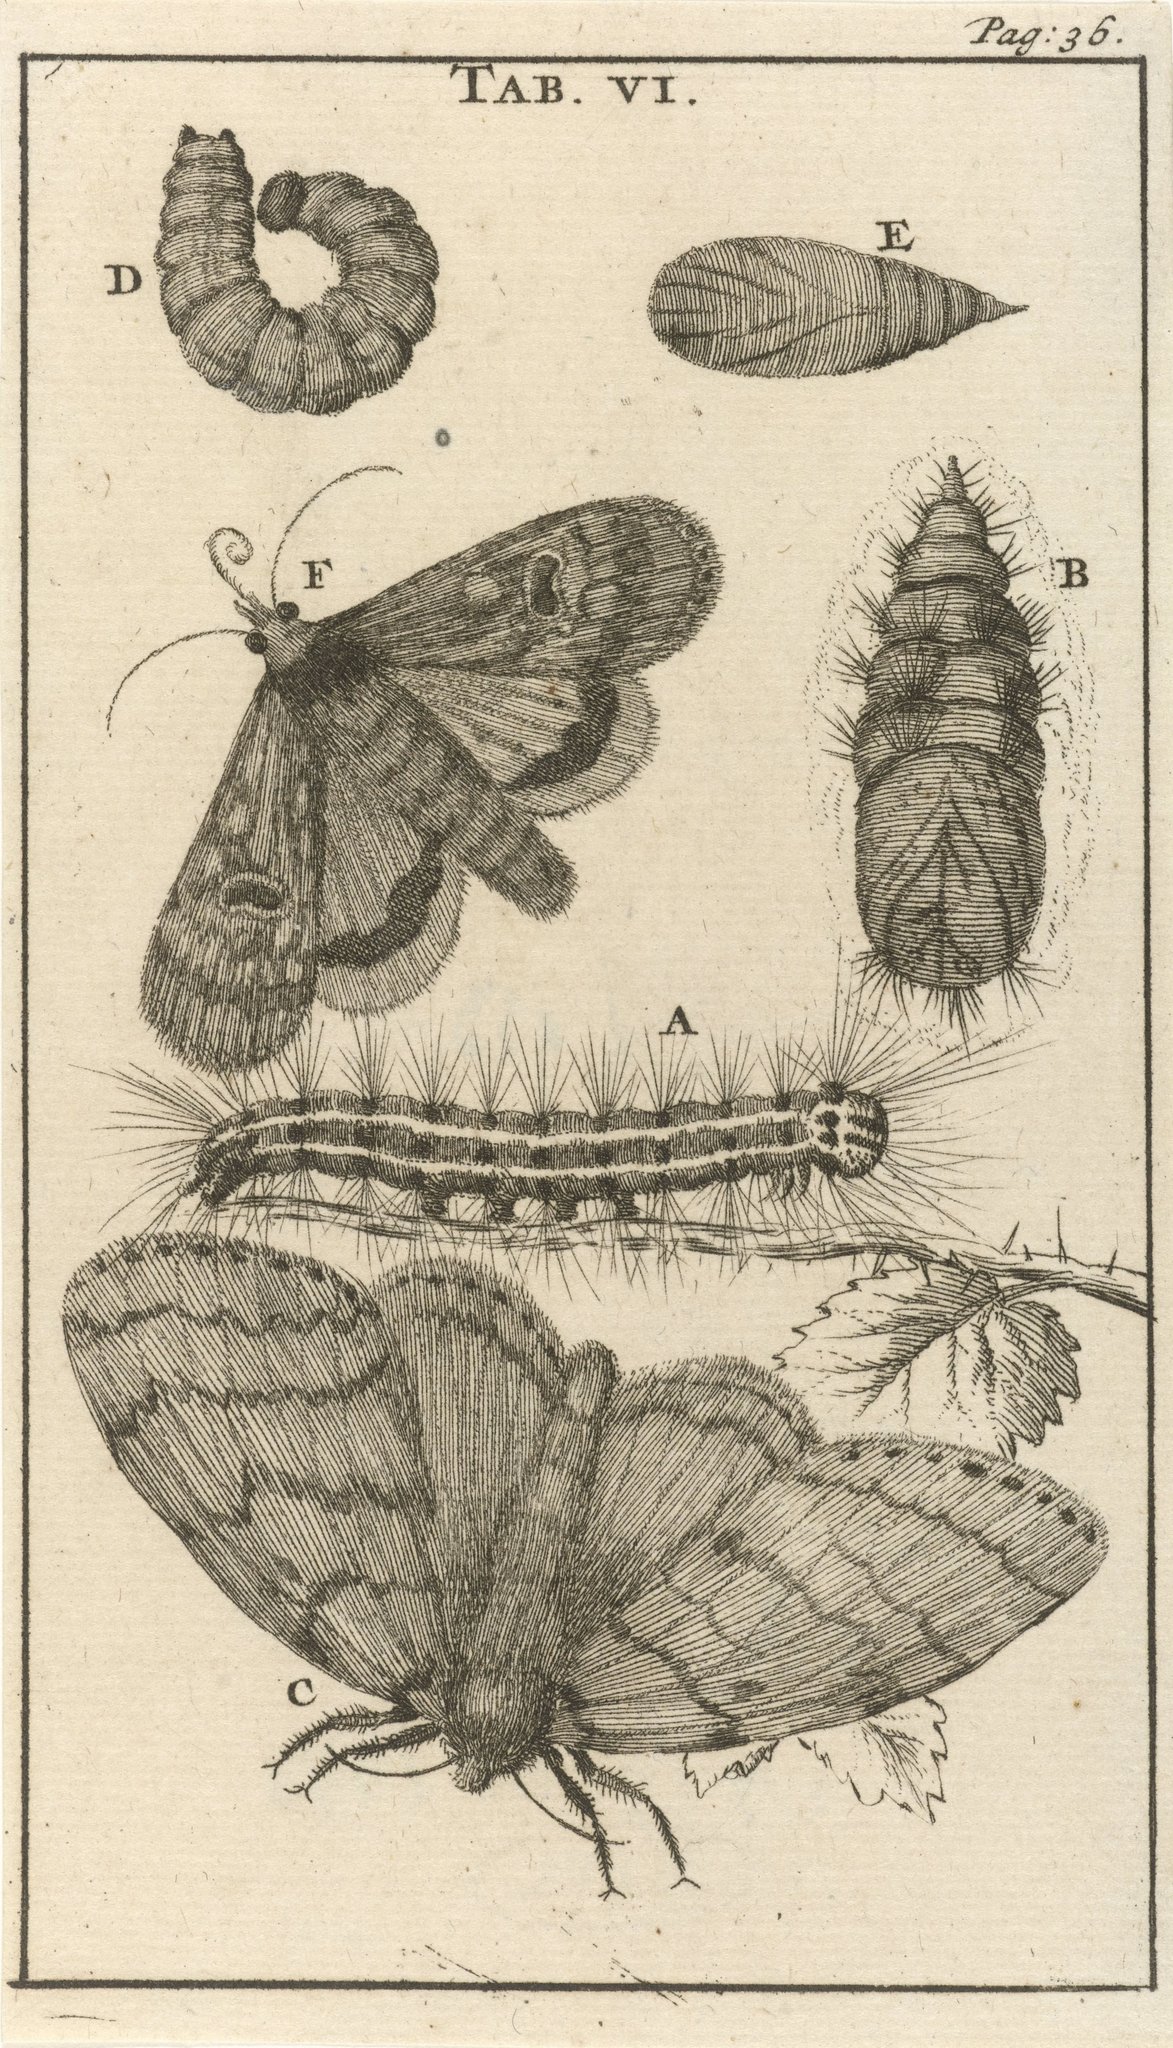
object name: print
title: Rupsen, poppen en vlinders VI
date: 1680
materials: paper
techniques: etching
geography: amsterdam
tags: insects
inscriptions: collector's mark: Lugt 2228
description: Illustratie opgenomen in: Blankaart, Steven. Schou-burg der rupsen, wormen, ma'den, en vliegende dierkens daar uit voortkomende. Amsterdam: Jan Claesz ten Hoorn, 1680.